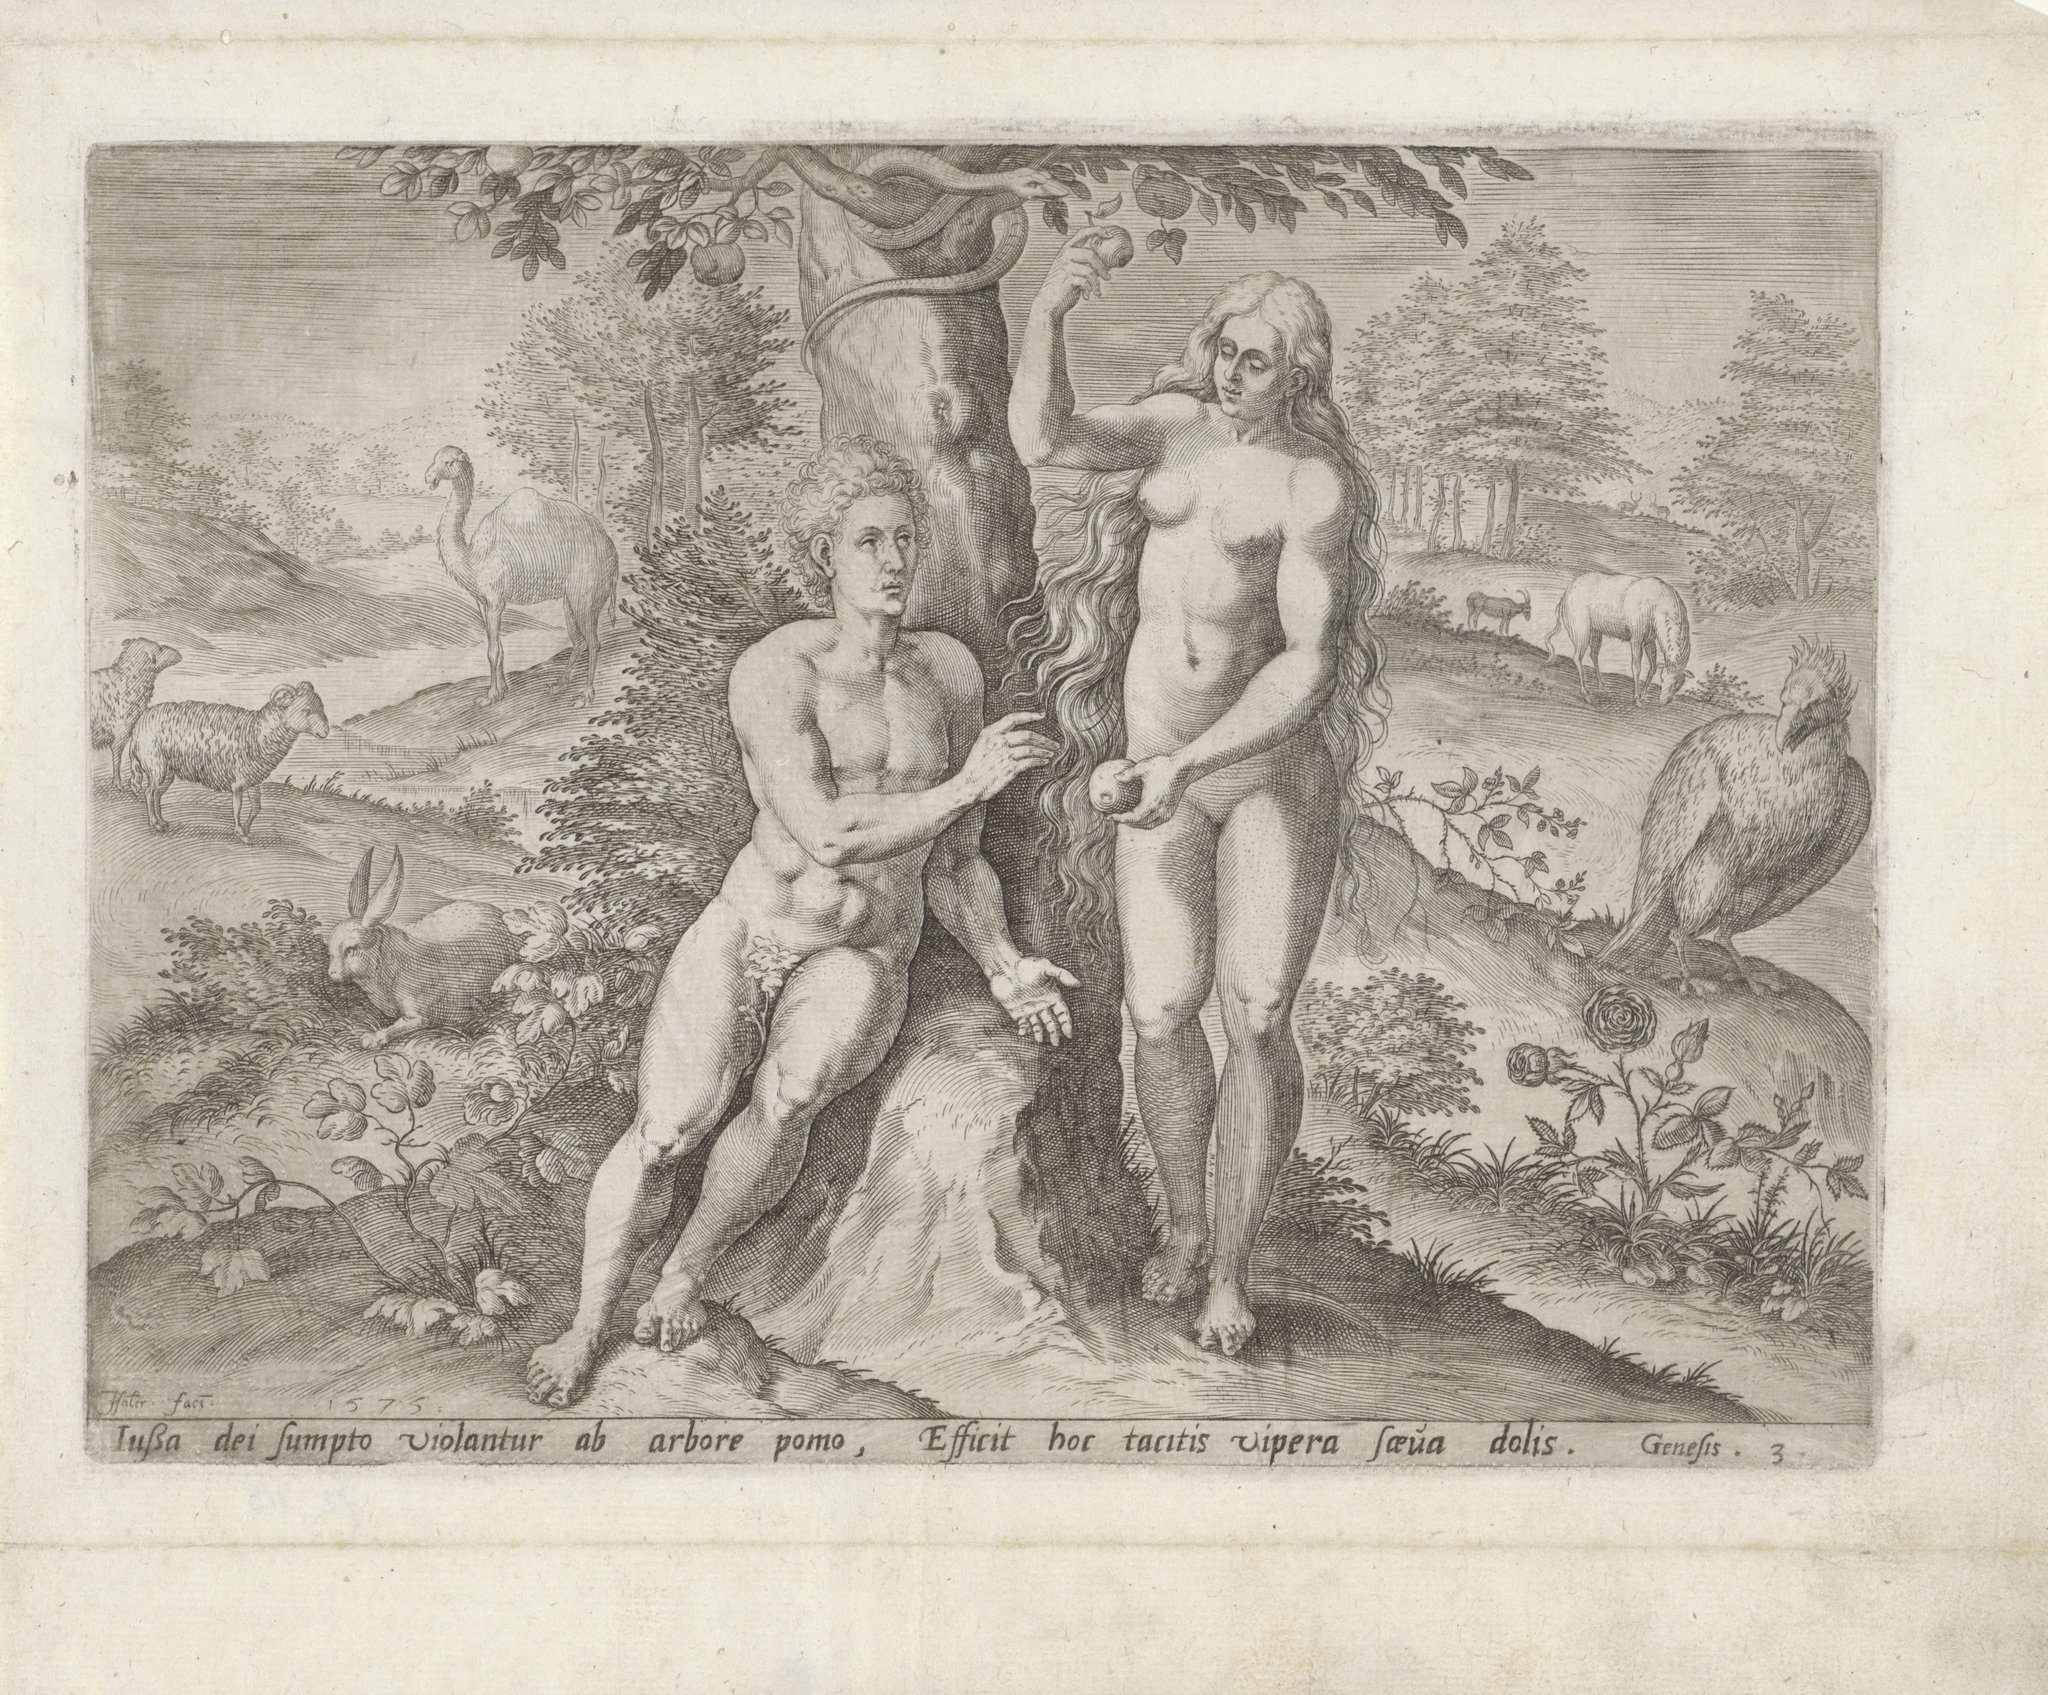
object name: print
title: Schepping en zondeval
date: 1575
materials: paper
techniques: engraving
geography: antwerp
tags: eve simultaneously offers some of the fruit to adam and takes some more from the serpent (or the tree), animals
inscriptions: collector's mark: Lugt 2228, collector's mark: Lugt 2760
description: Eva biedt Adam een vrucht aan de appel aan van de boom van de kennis van goed en kwaad. In de boom de slang. Verschillende dieren op de achtergrond. De vijfde prent van een achtdelige reeks over het scheppingsverhaal.